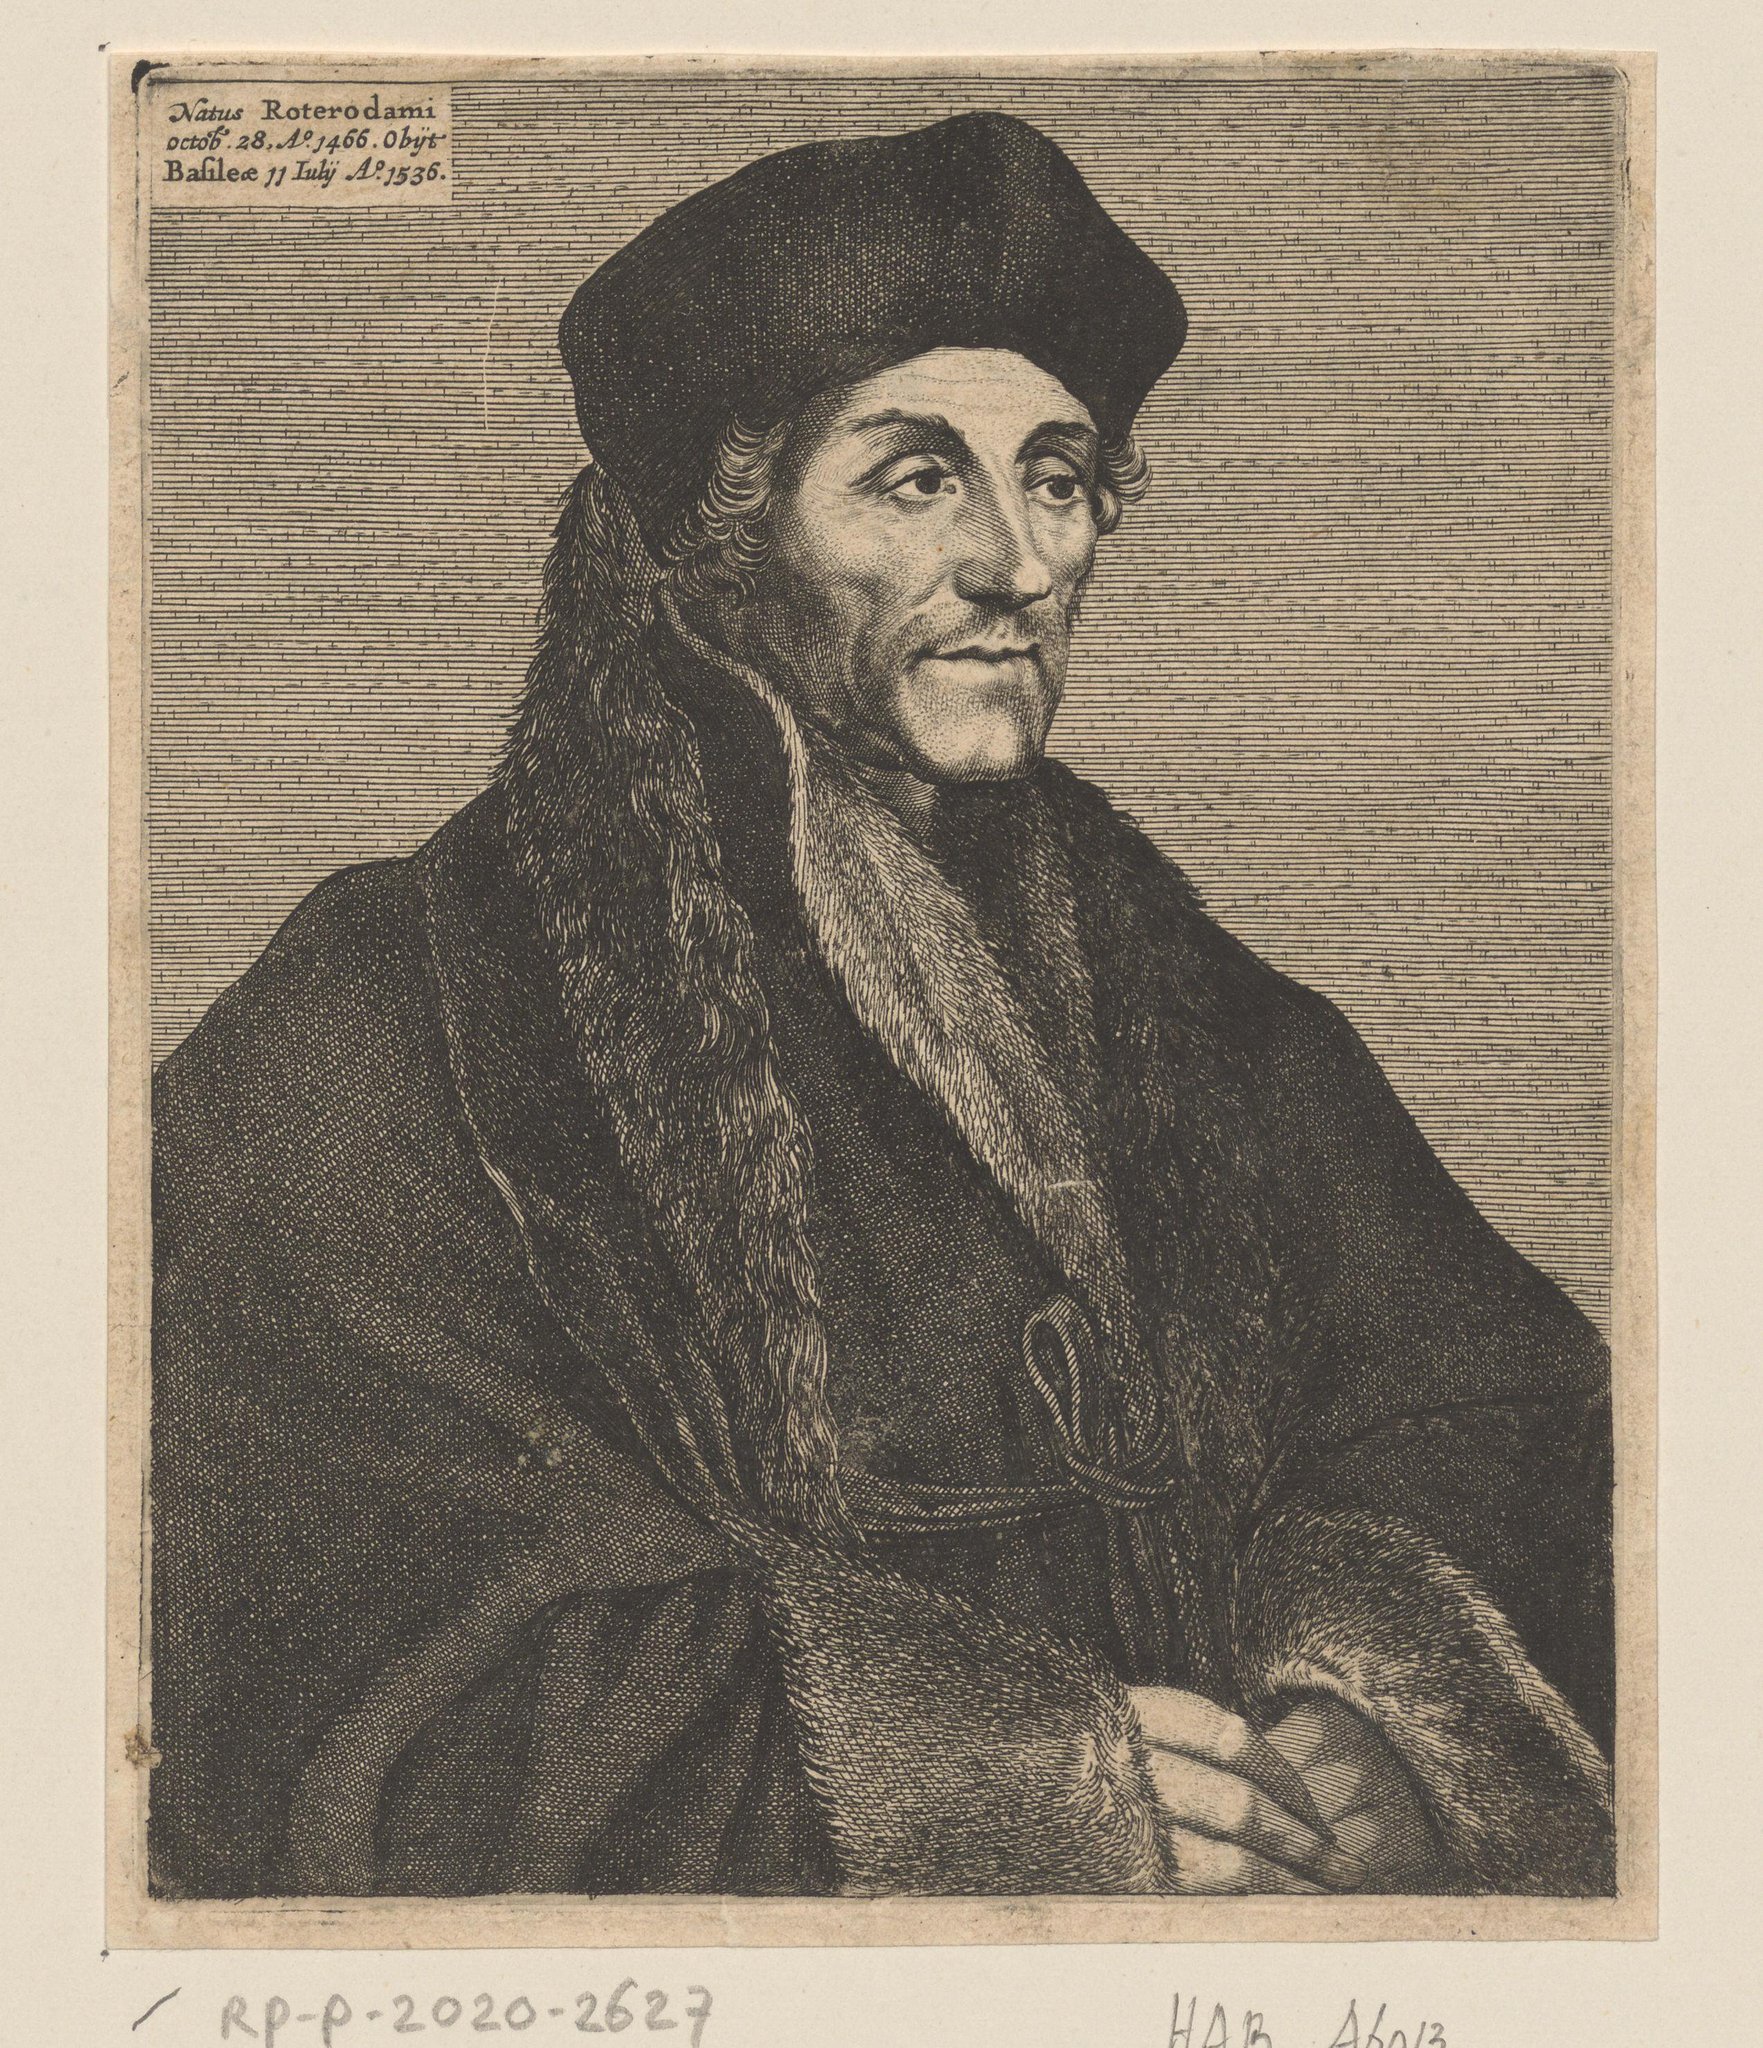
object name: print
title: Portret van Desiderius Erasmus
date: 1630-1680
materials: paper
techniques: engraving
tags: rotterdam, desiderius erasmus, historical persons, scholar, philosopher (+ portrait of scholar, scientist)